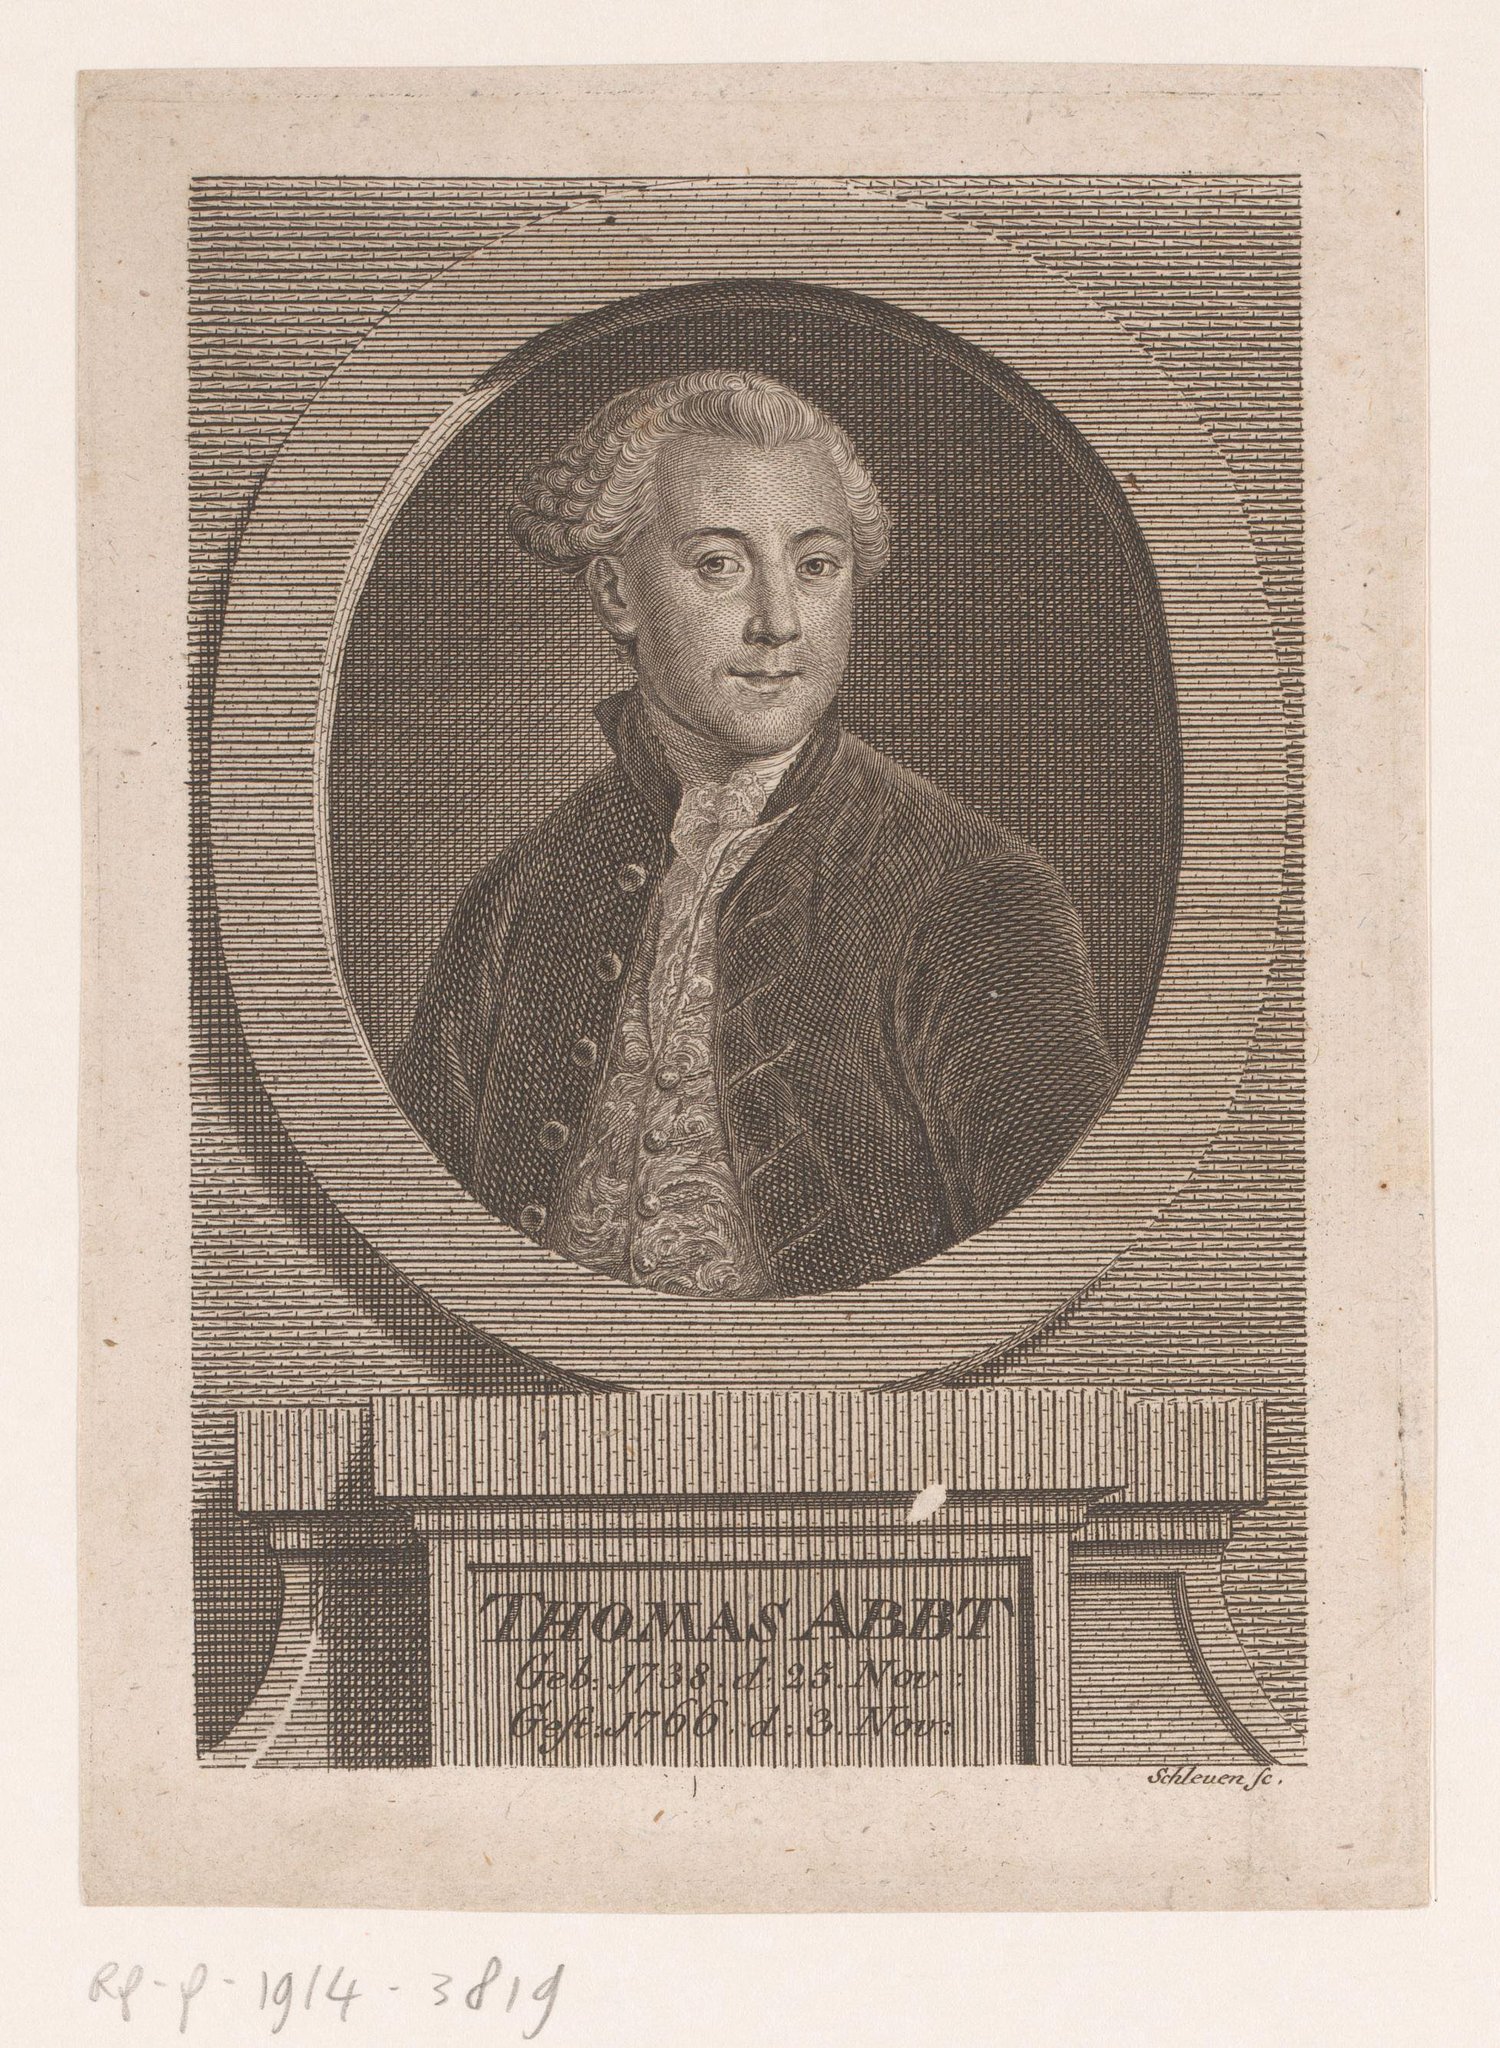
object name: print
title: Portret van Thomas Abbt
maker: johann david schleuen (i)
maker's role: print maker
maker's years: 1711-1774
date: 1766-1771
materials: paper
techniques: engraving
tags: historical persons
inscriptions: collector's mark: Lugt 2228